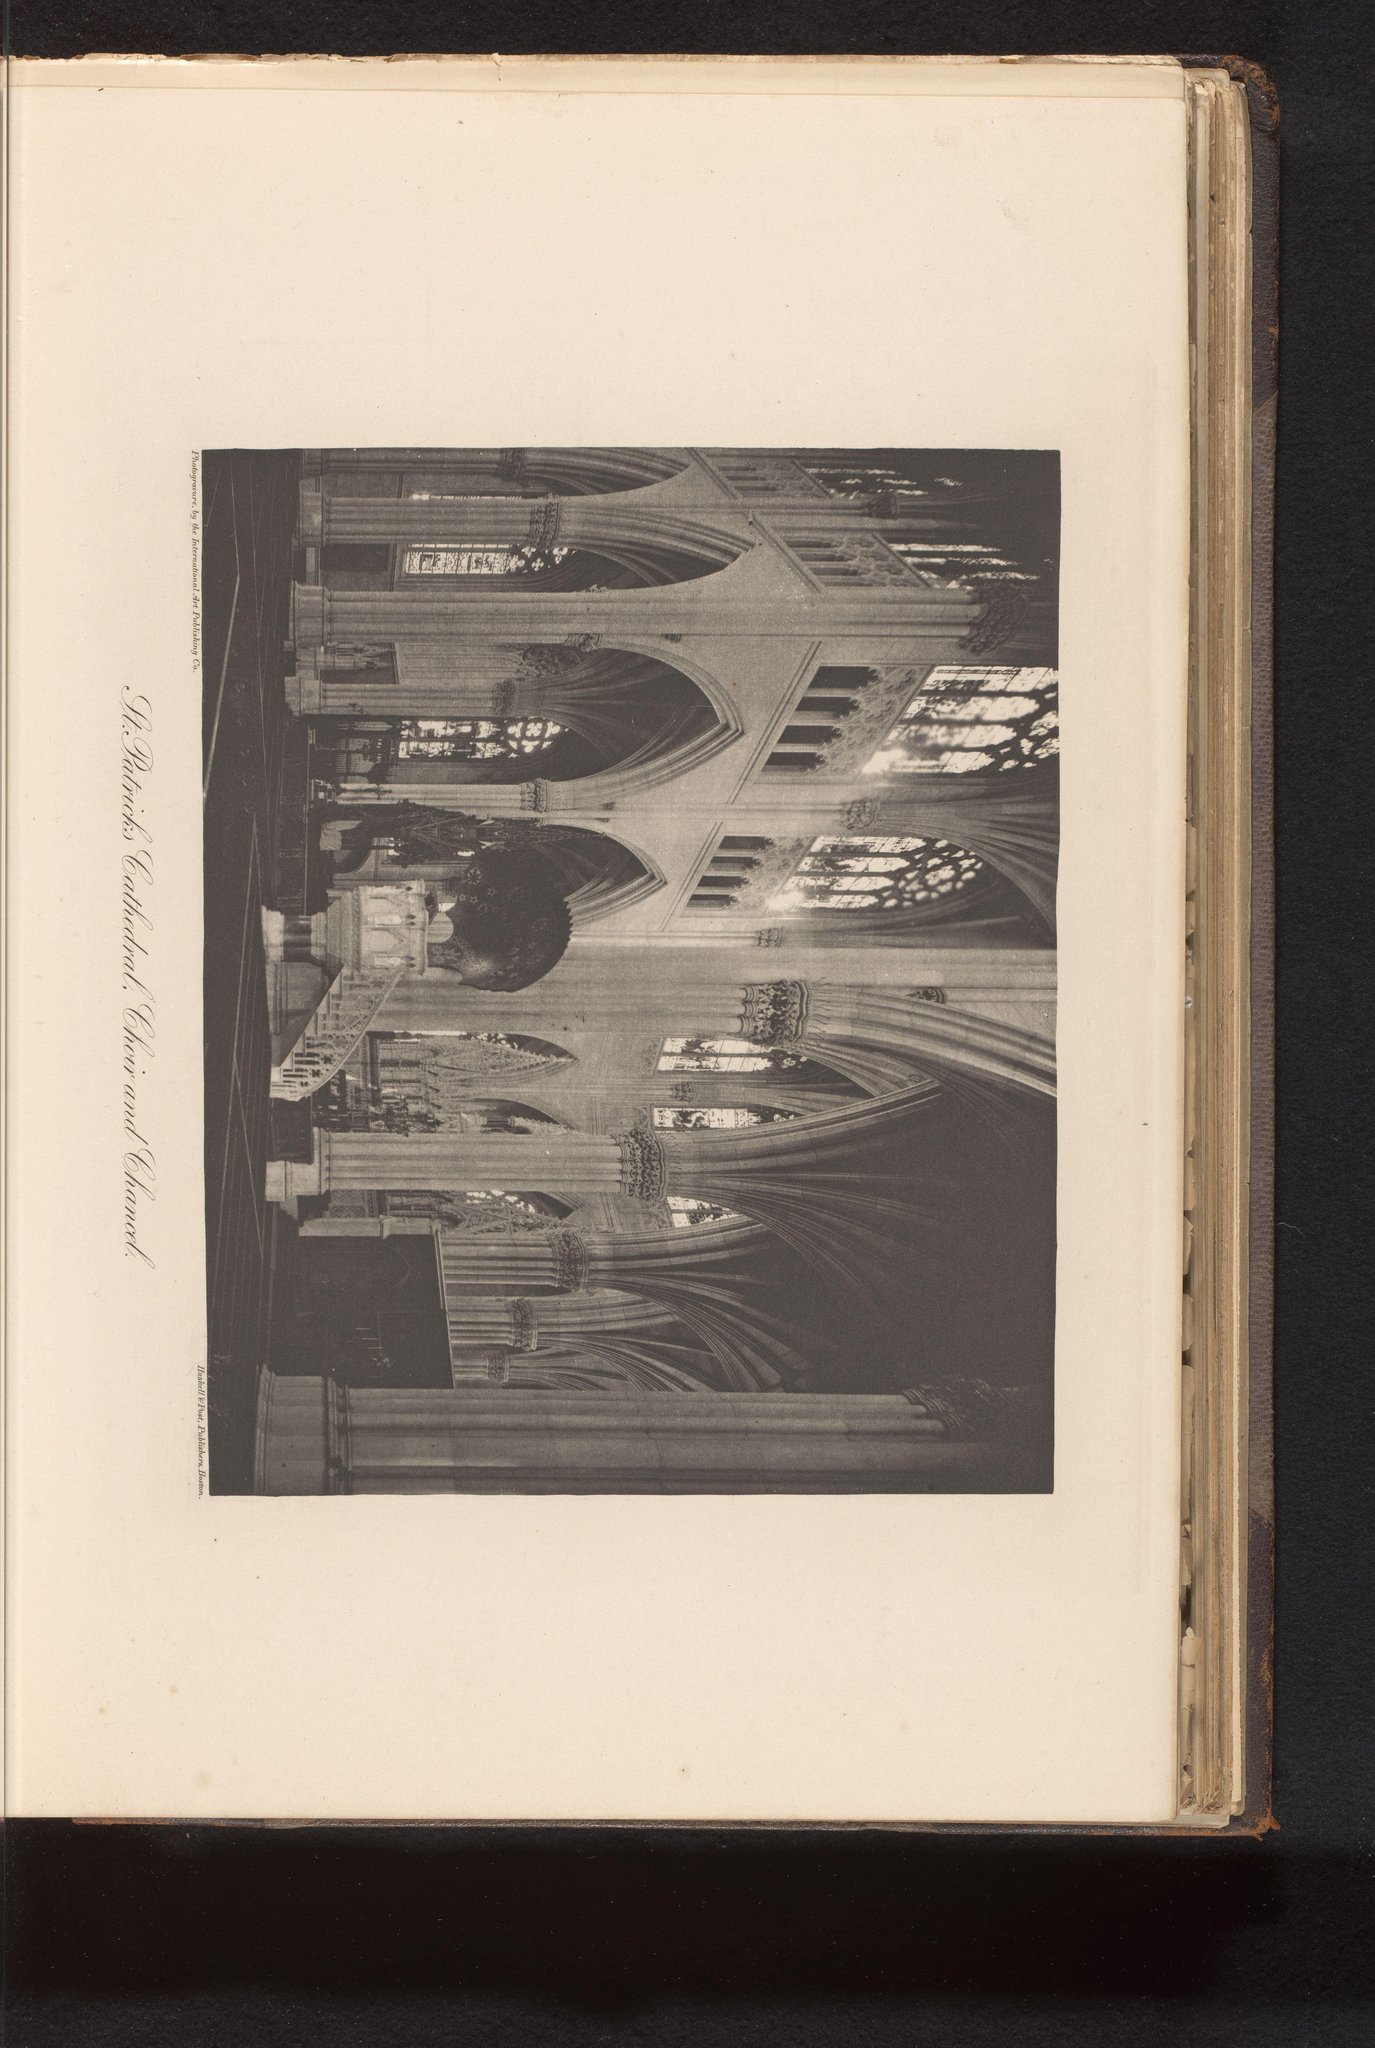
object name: photomechanical print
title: Koor en de preekstoel in de Saint Patrick's Cathedral te New York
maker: Anonymous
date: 1881-1886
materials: paper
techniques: photograph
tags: pulpit, ambo, chancel, parts of church interior: choir